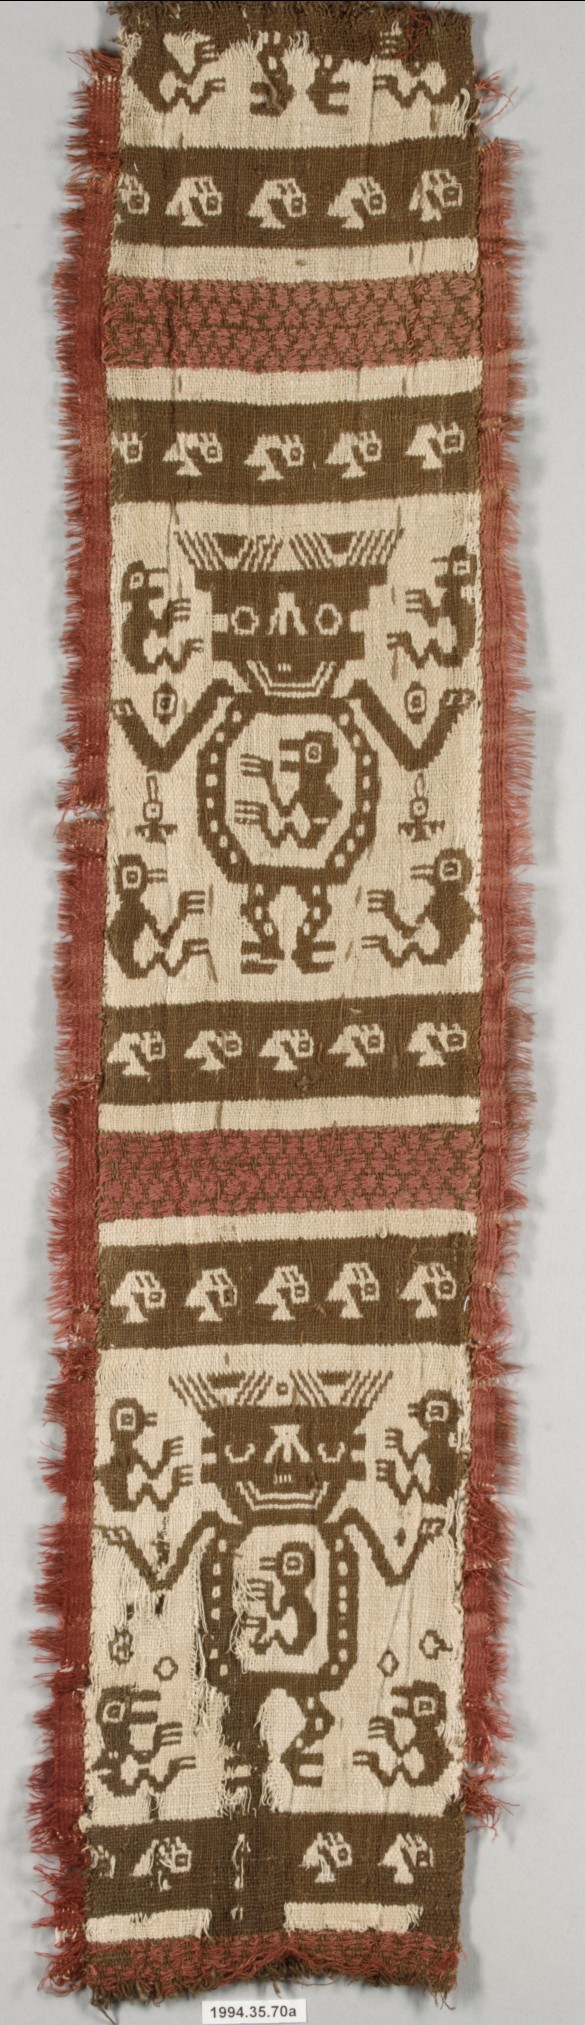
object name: sash fragment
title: Sash Fragments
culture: peruvian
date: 1301-1533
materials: animal fiber, cotton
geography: peru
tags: animals